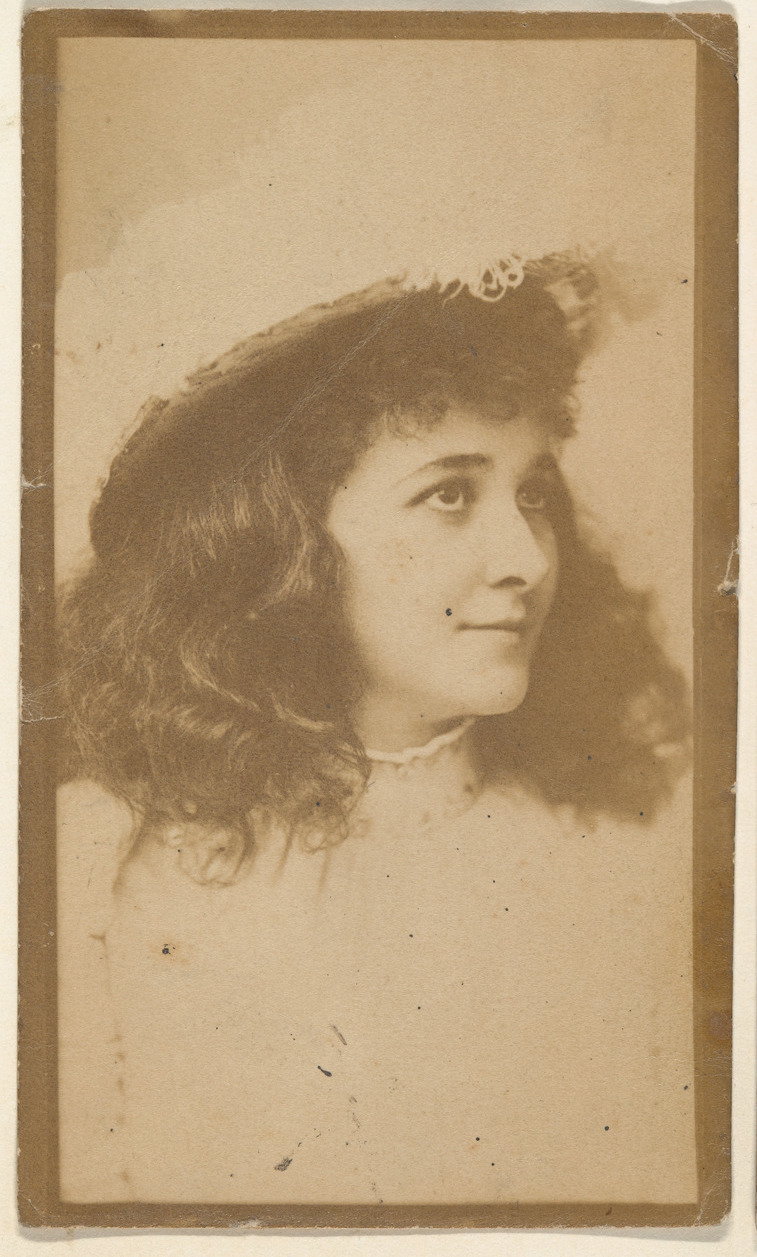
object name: photograph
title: Portrait of actress wearing feathered hat, from the Actresses series (N668)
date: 1888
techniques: albumen silver print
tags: portraits,women,actresses